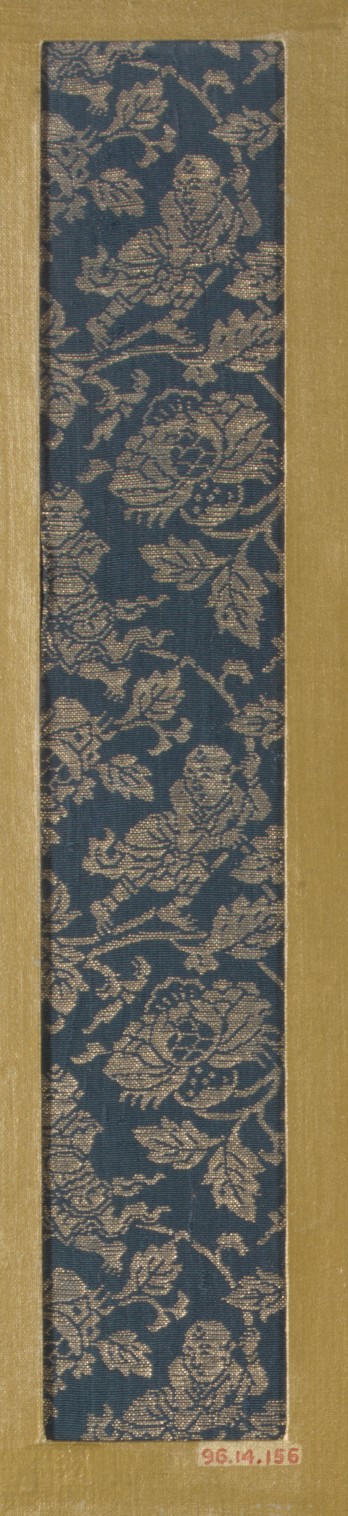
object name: fragment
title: Textile fragment with pattern of Chinese boys on flowering branches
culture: japanese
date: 1701-1900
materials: silk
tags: flowers,leaves